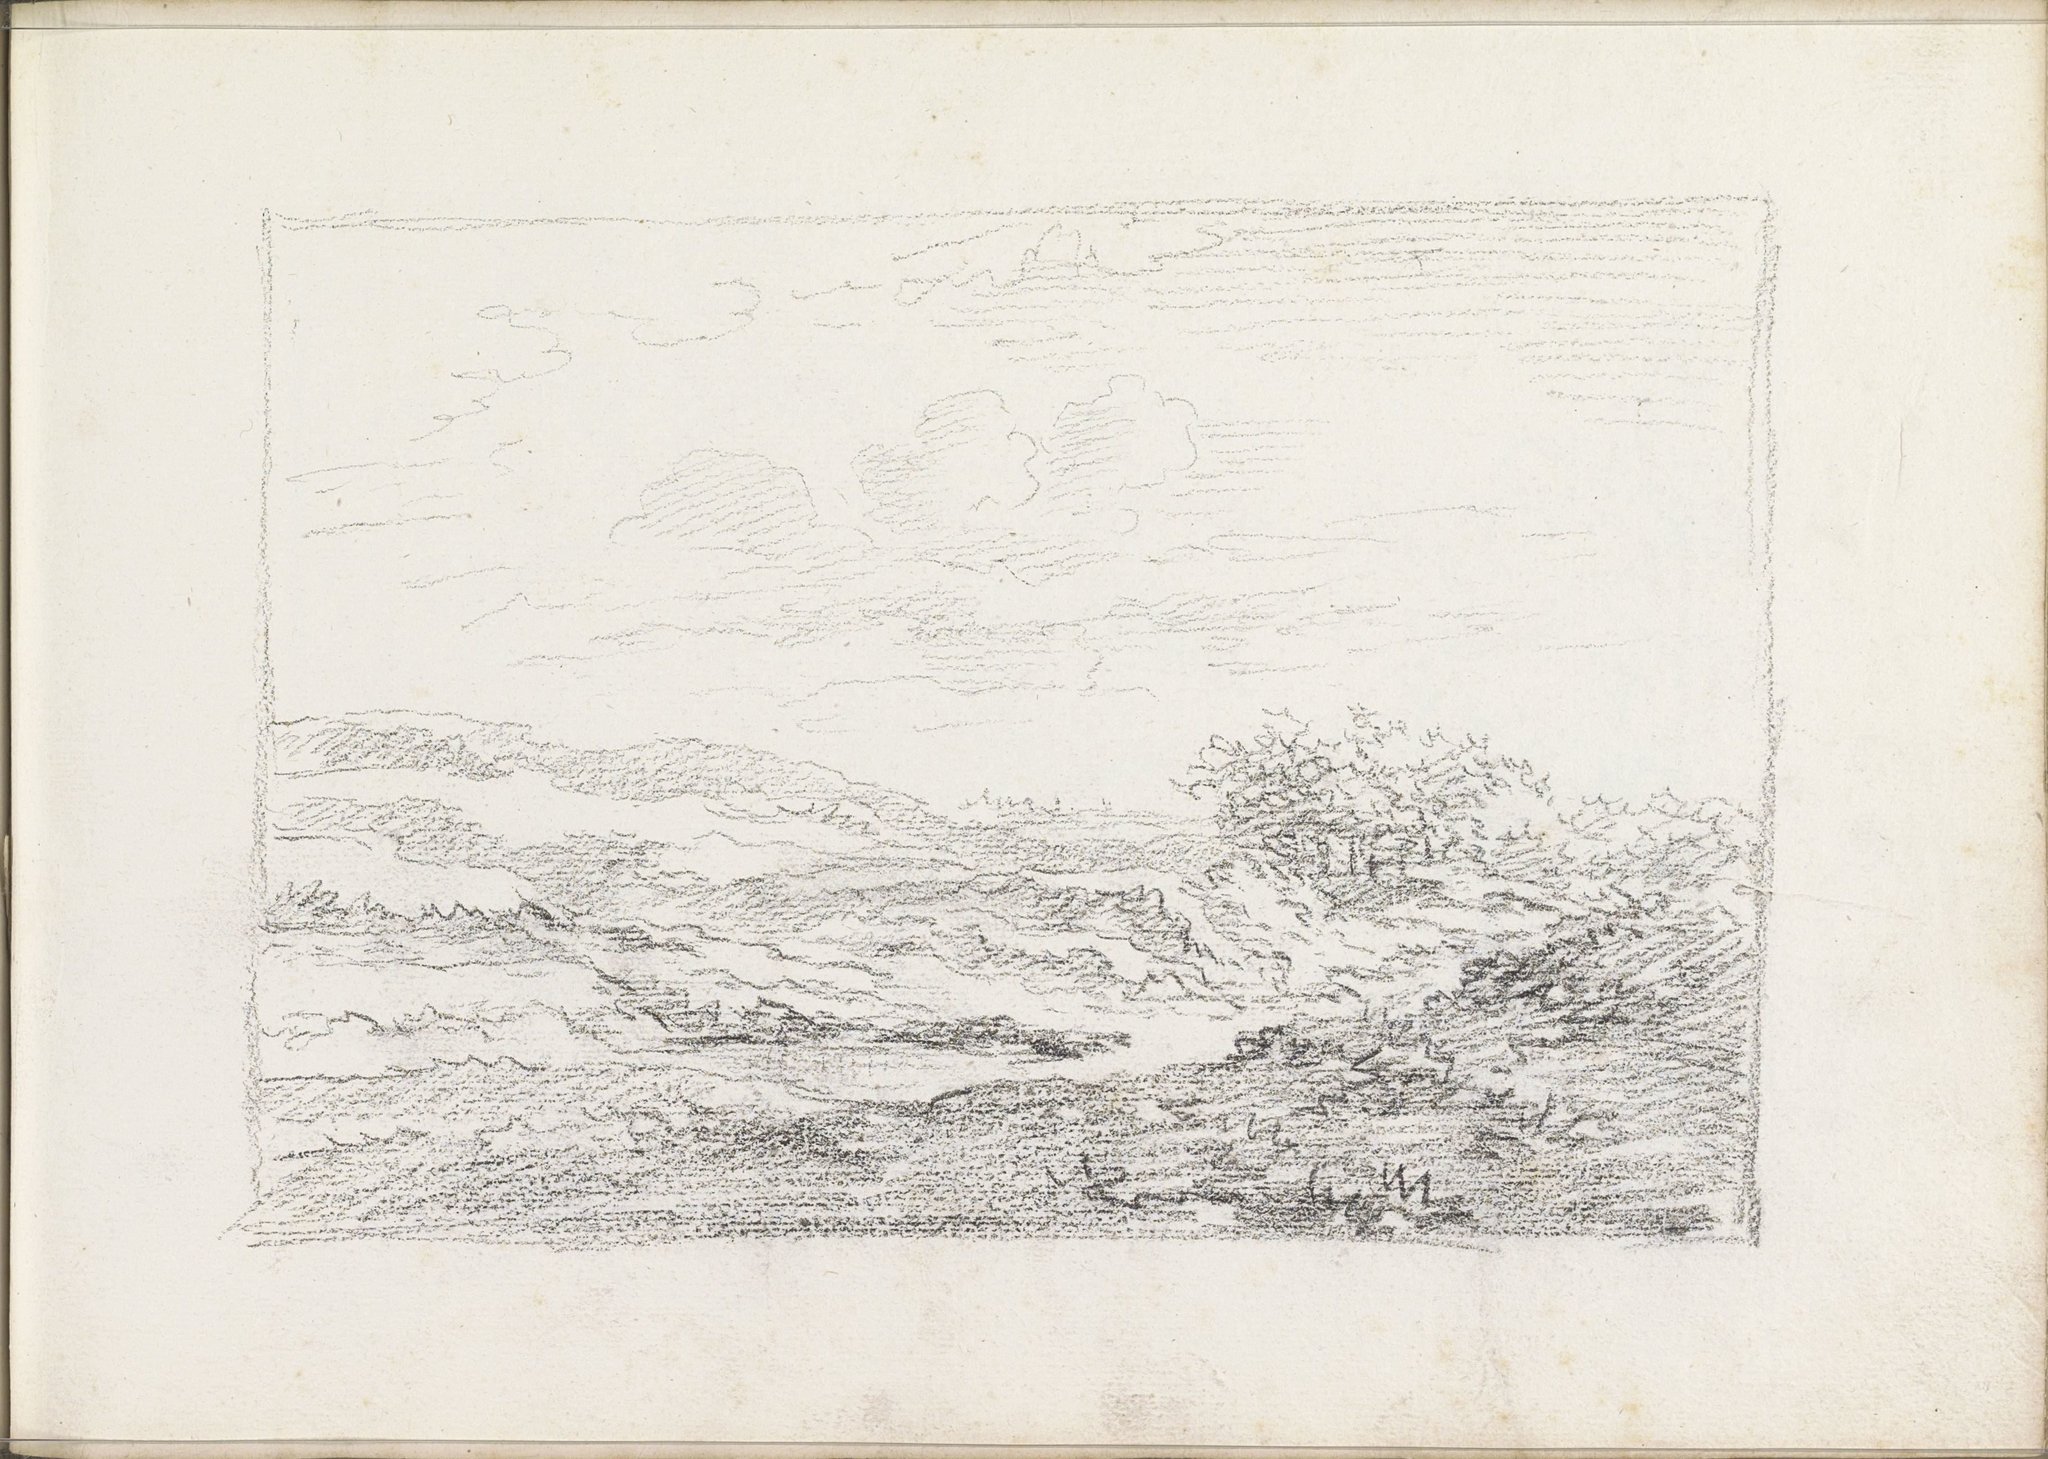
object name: sketchbook leaf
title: Heuvellandschap met bomen en struiken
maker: andreas schelfhout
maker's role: draughtsman, painter, print maker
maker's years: 1787-1870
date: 1811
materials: chalk, paper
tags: low hill country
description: Blad 58 recto uit een schetsboek met 75 bladen.